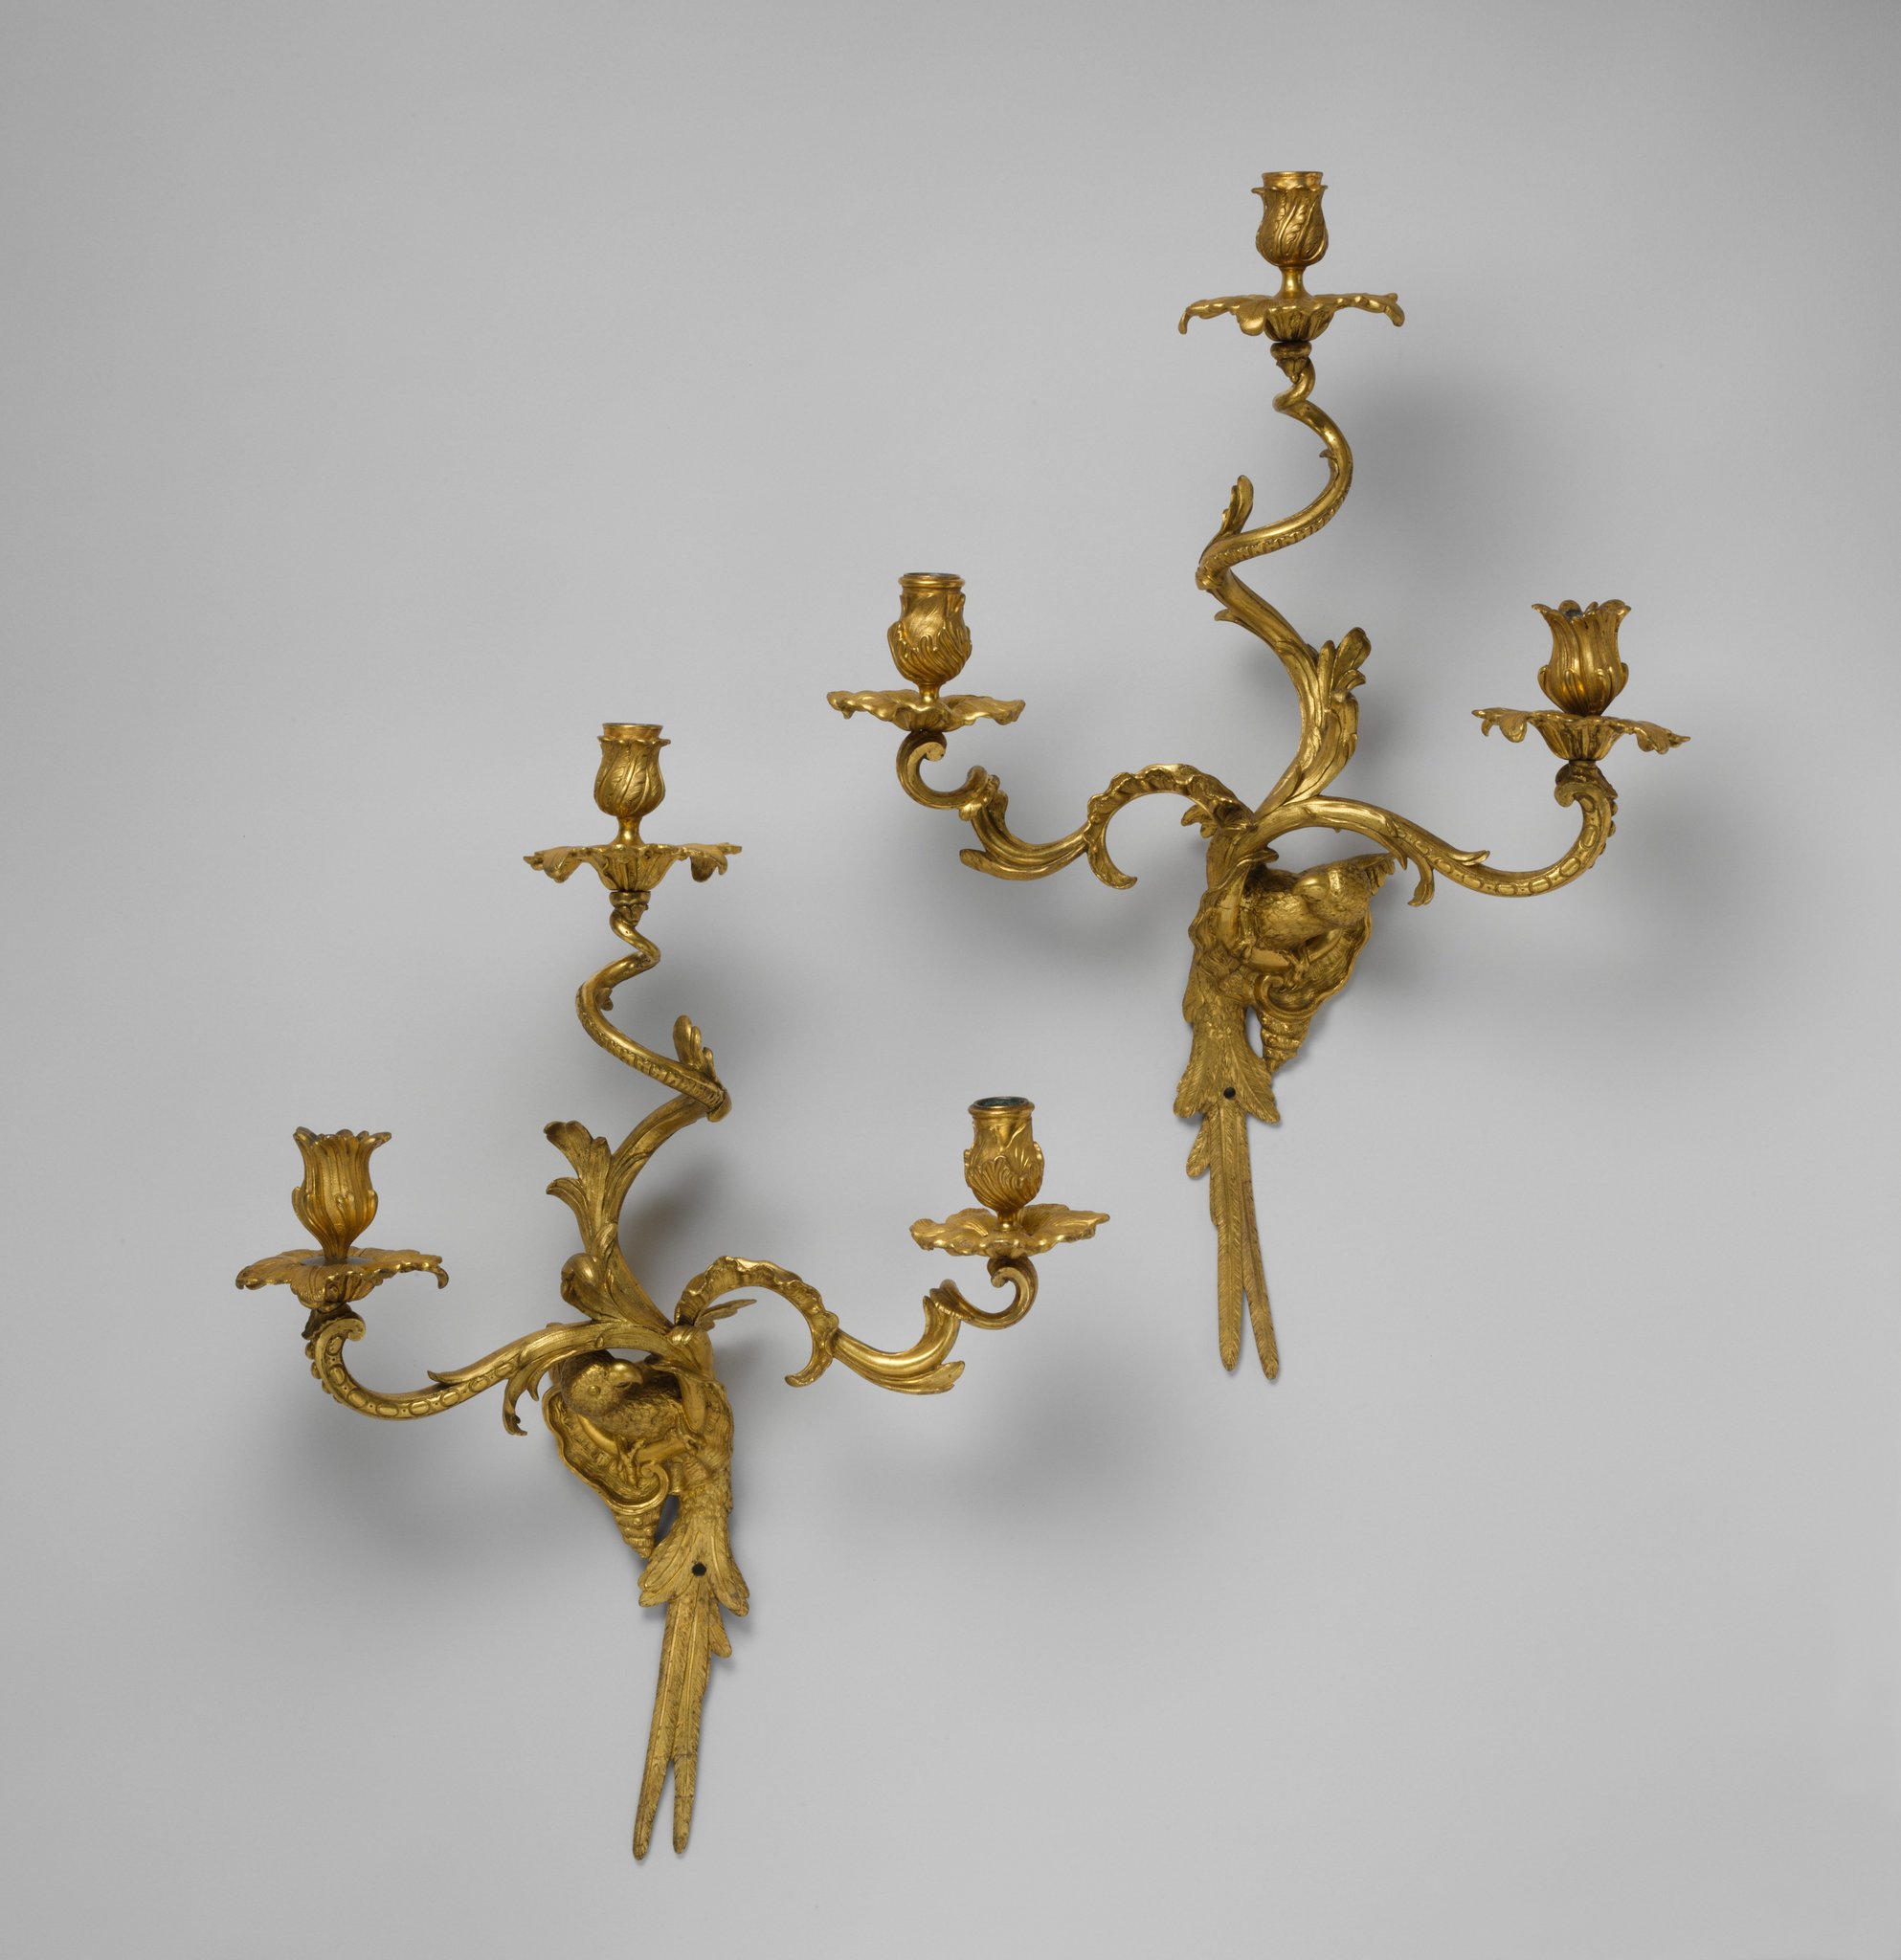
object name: wall bracket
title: Set of four three-light wall brackets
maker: charles cressent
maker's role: designer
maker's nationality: french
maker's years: 1685-1768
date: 1745-1749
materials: gilt bronze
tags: birds